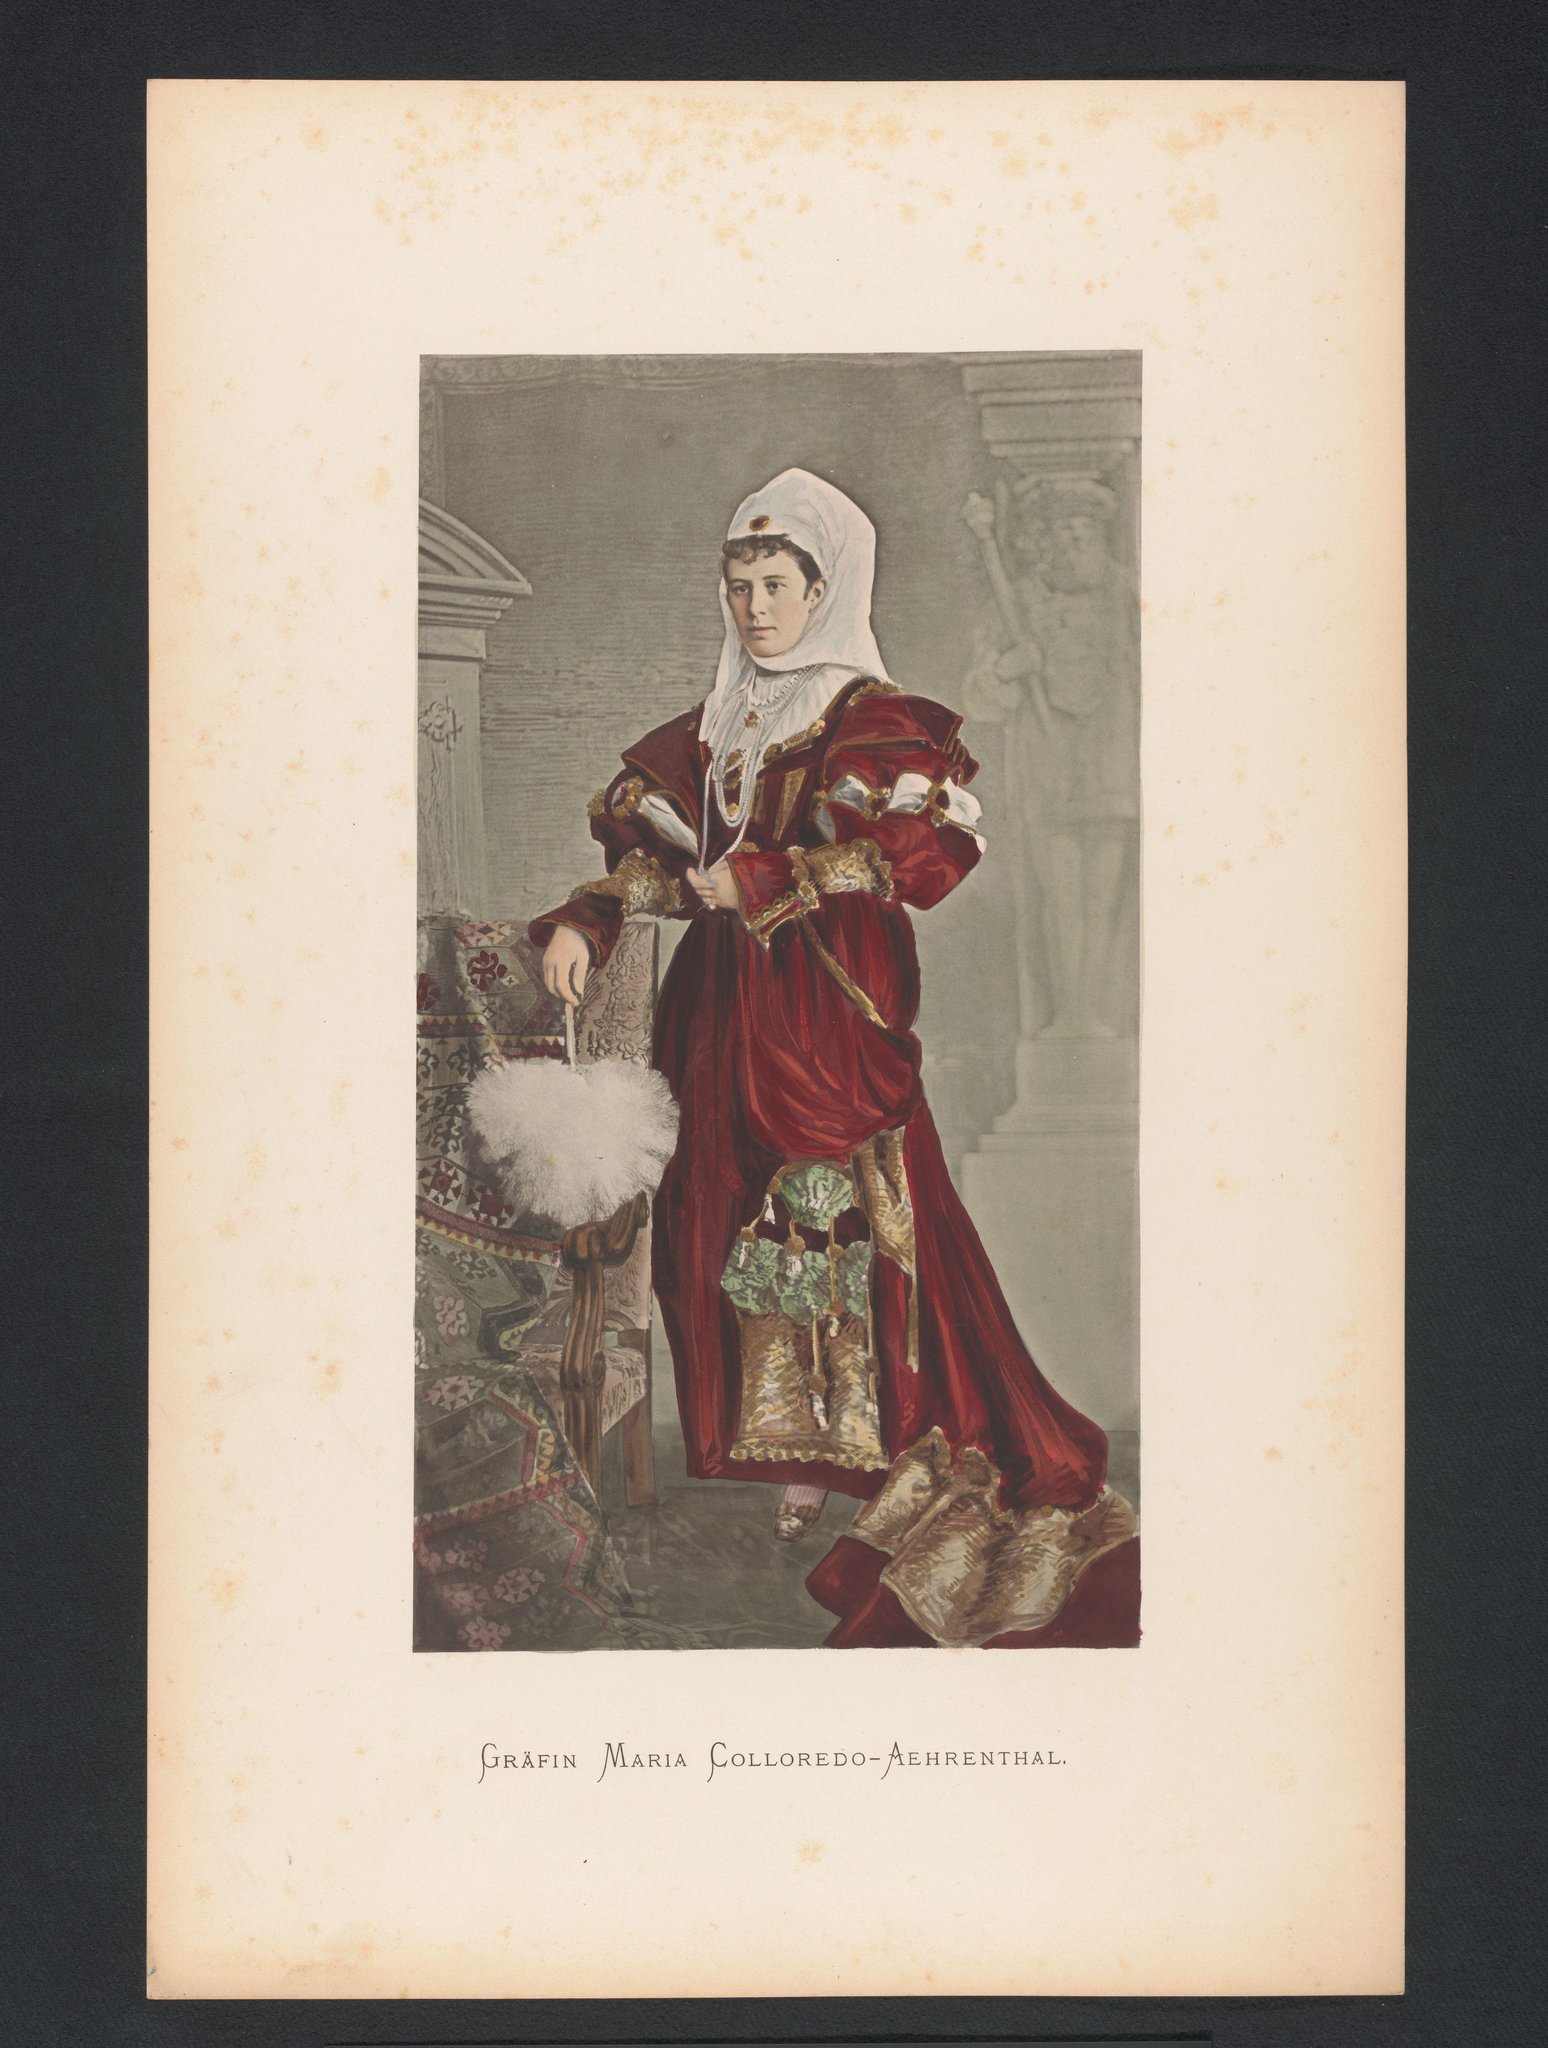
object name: photomechanical print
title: Gräfin Maria Colloredo-Aehrenthal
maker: Anonymous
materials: paper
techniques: photograph, hand coloring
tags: historical persons - bb - woman, aristocracy; 'aristocratia' (ripa)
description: Deze prent maakt deel uit van een omslag met 86 prenten op 78 bladen en 11 tekstbladen.